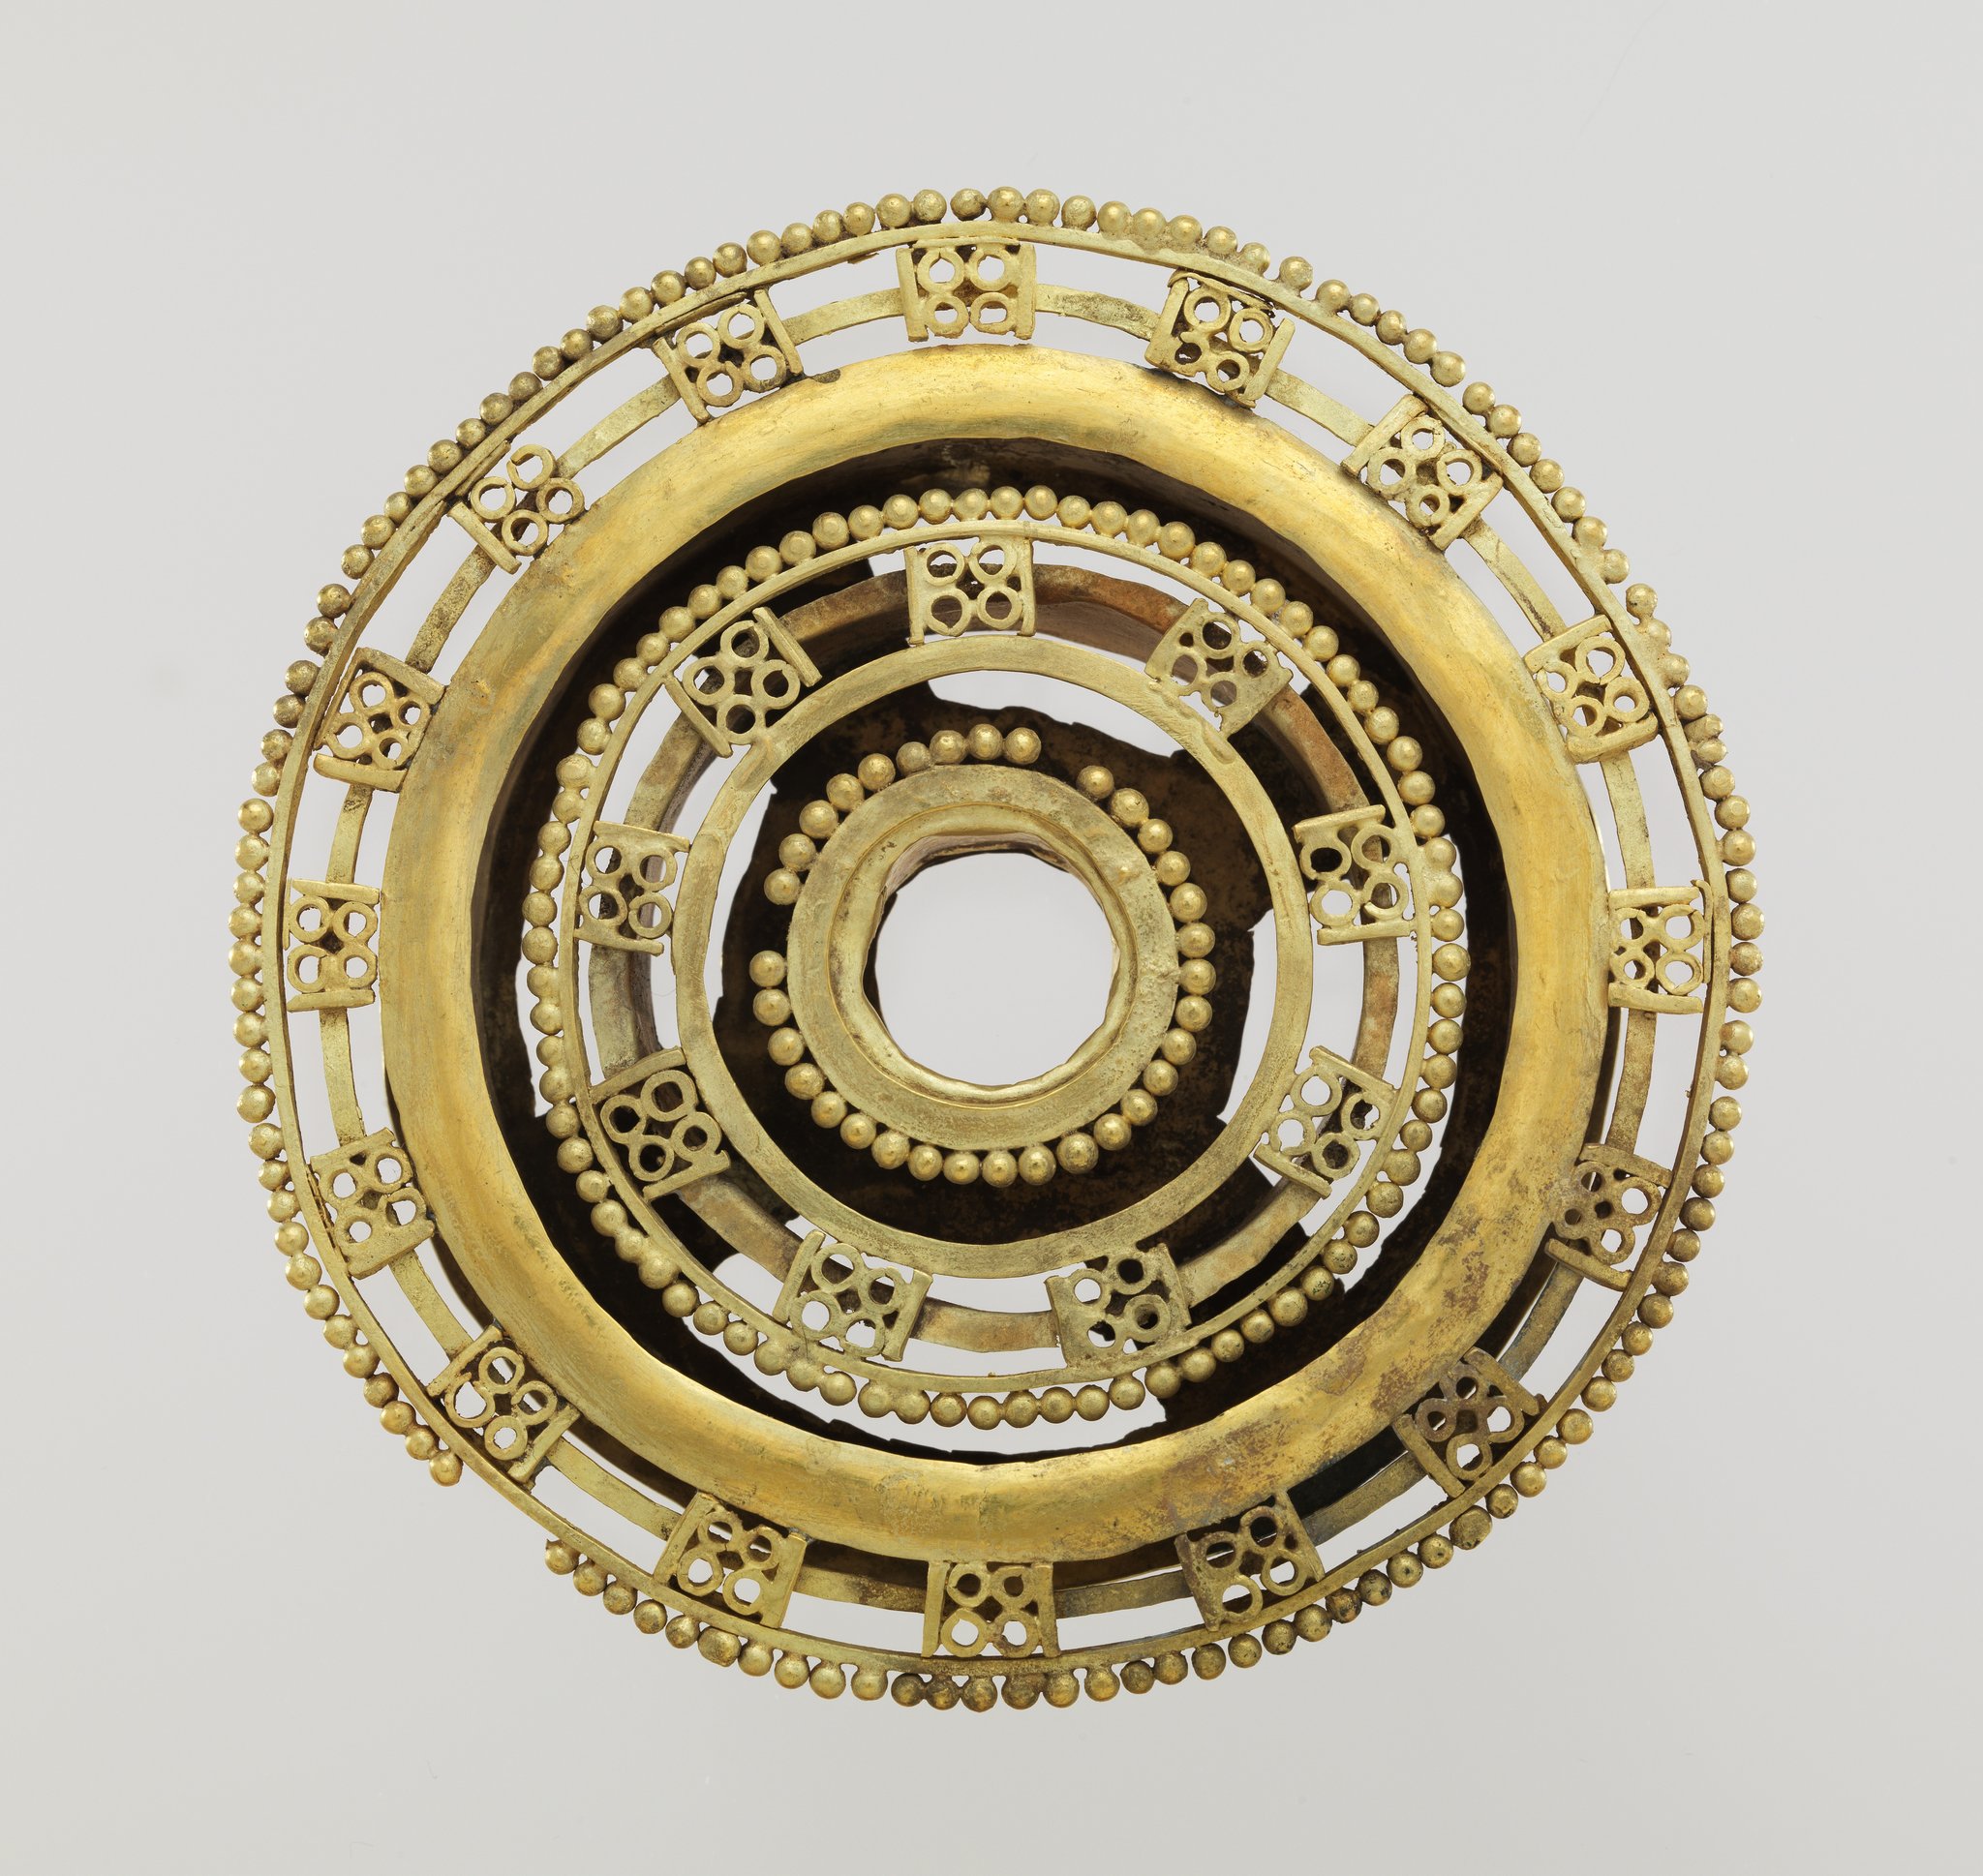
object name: earflare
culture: lambayeque, sicán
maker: lambayeque (sicán) artist(s)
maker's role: artist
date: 900-1100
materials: gold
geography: peru